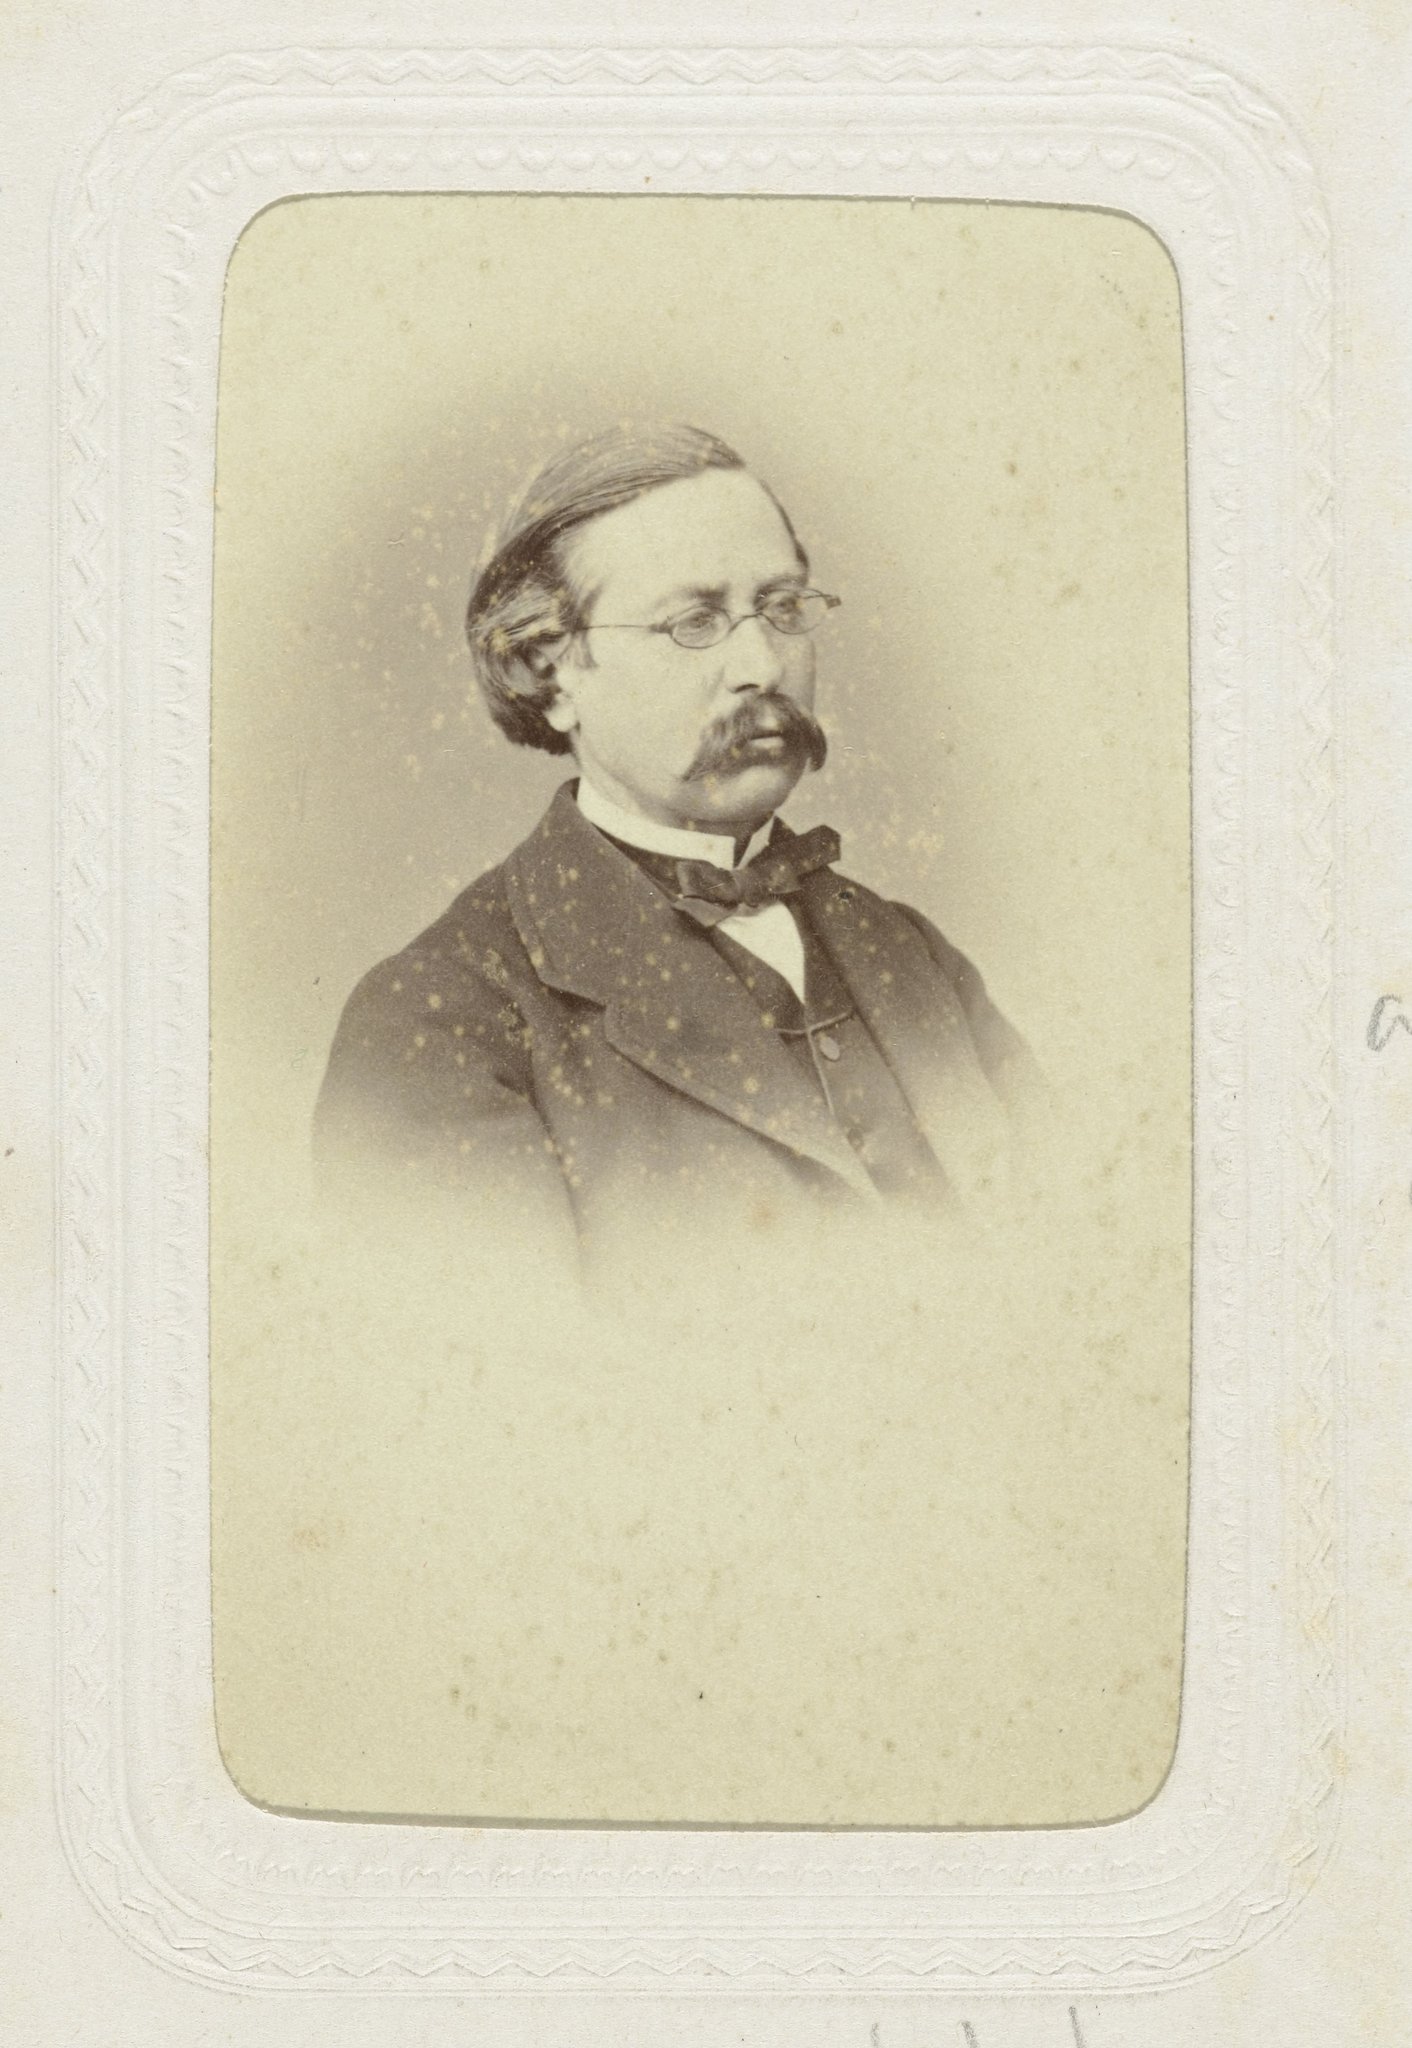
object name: carte de visite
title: Studioportret van een man met snor en bril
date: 1863-1866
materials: cardboard, paper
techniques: albumen print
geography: istanbul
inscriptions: name: ‘Abdullah freres, Constantinople’, name: ‘Mühlich’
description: De afgebeelde man is vermoedelijk de heer Mühlich.